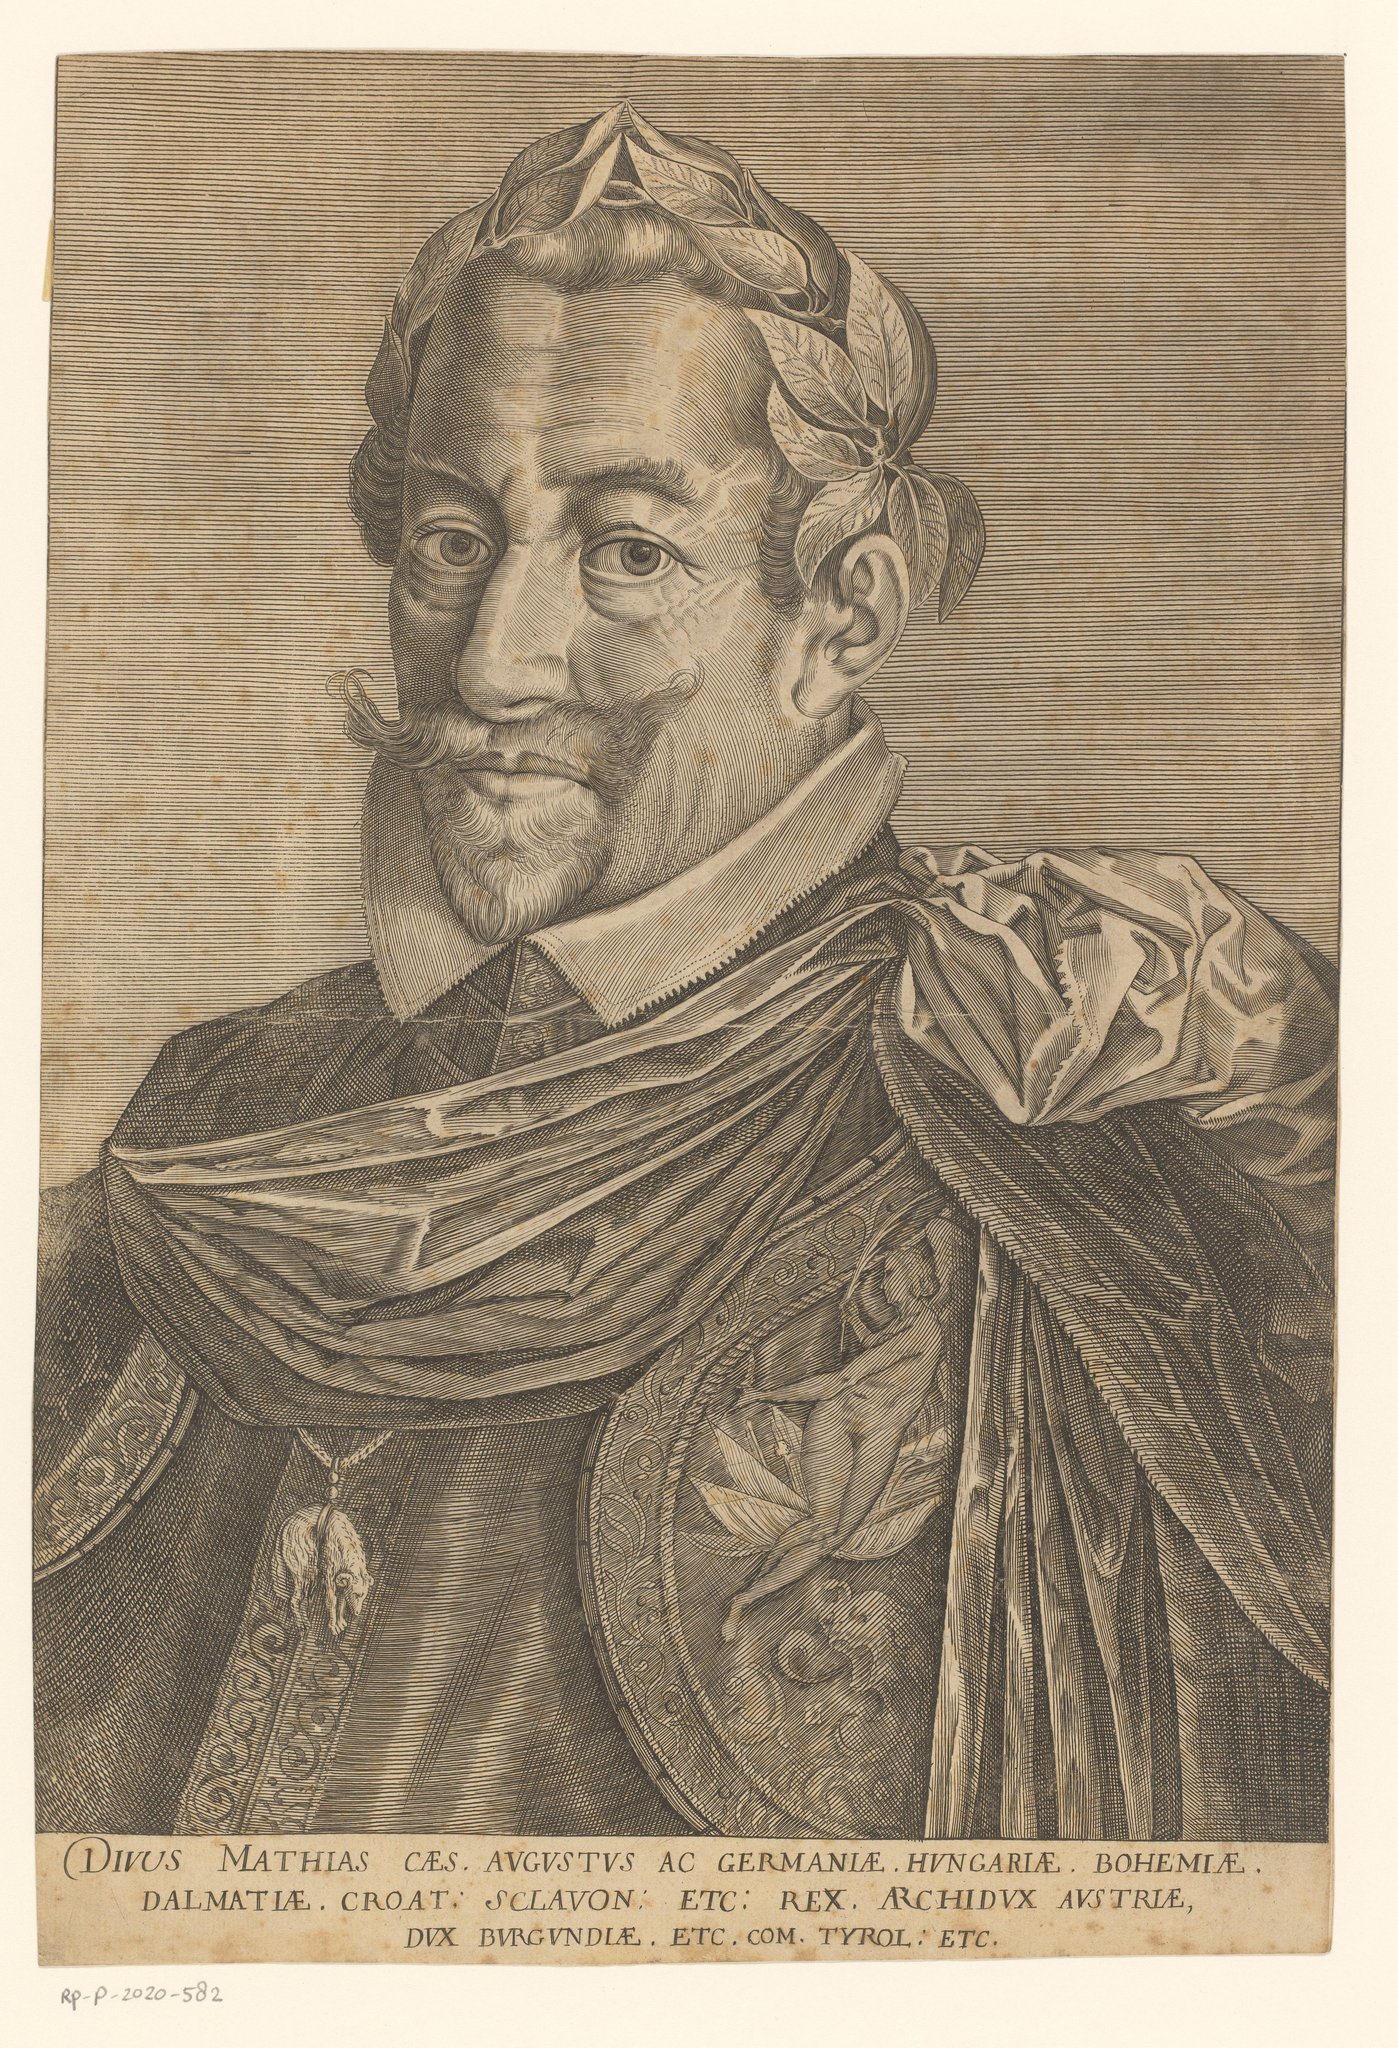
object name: print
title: Divus Mathias Caes (...)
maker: johannes eillarts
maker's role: print maker, publisher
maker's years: 1568-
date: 1611-1630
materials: paper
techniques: engraving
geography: leeuwarden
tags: vienna, matthias van oostenrijk (rooms-duits keizer), historical persons, knighthood order of the golden fleece - insignia of a knighthood order, e.g.: badge, chain (with name of order)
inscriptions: collector's mark: Lugt 2228, collector's mark: Lugt 2760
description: Busteportret van Matthias van Oostenrijk (1557-1619), keizer van het Heilige Roomse Rijk en landvoogd der Nederlanden, afgebeeld in toga, met laurierkrans op het hoofd en een ketting met insigne van de Orde van het Gulden Vlies. Onder de voorstelling drie regels Latijn.